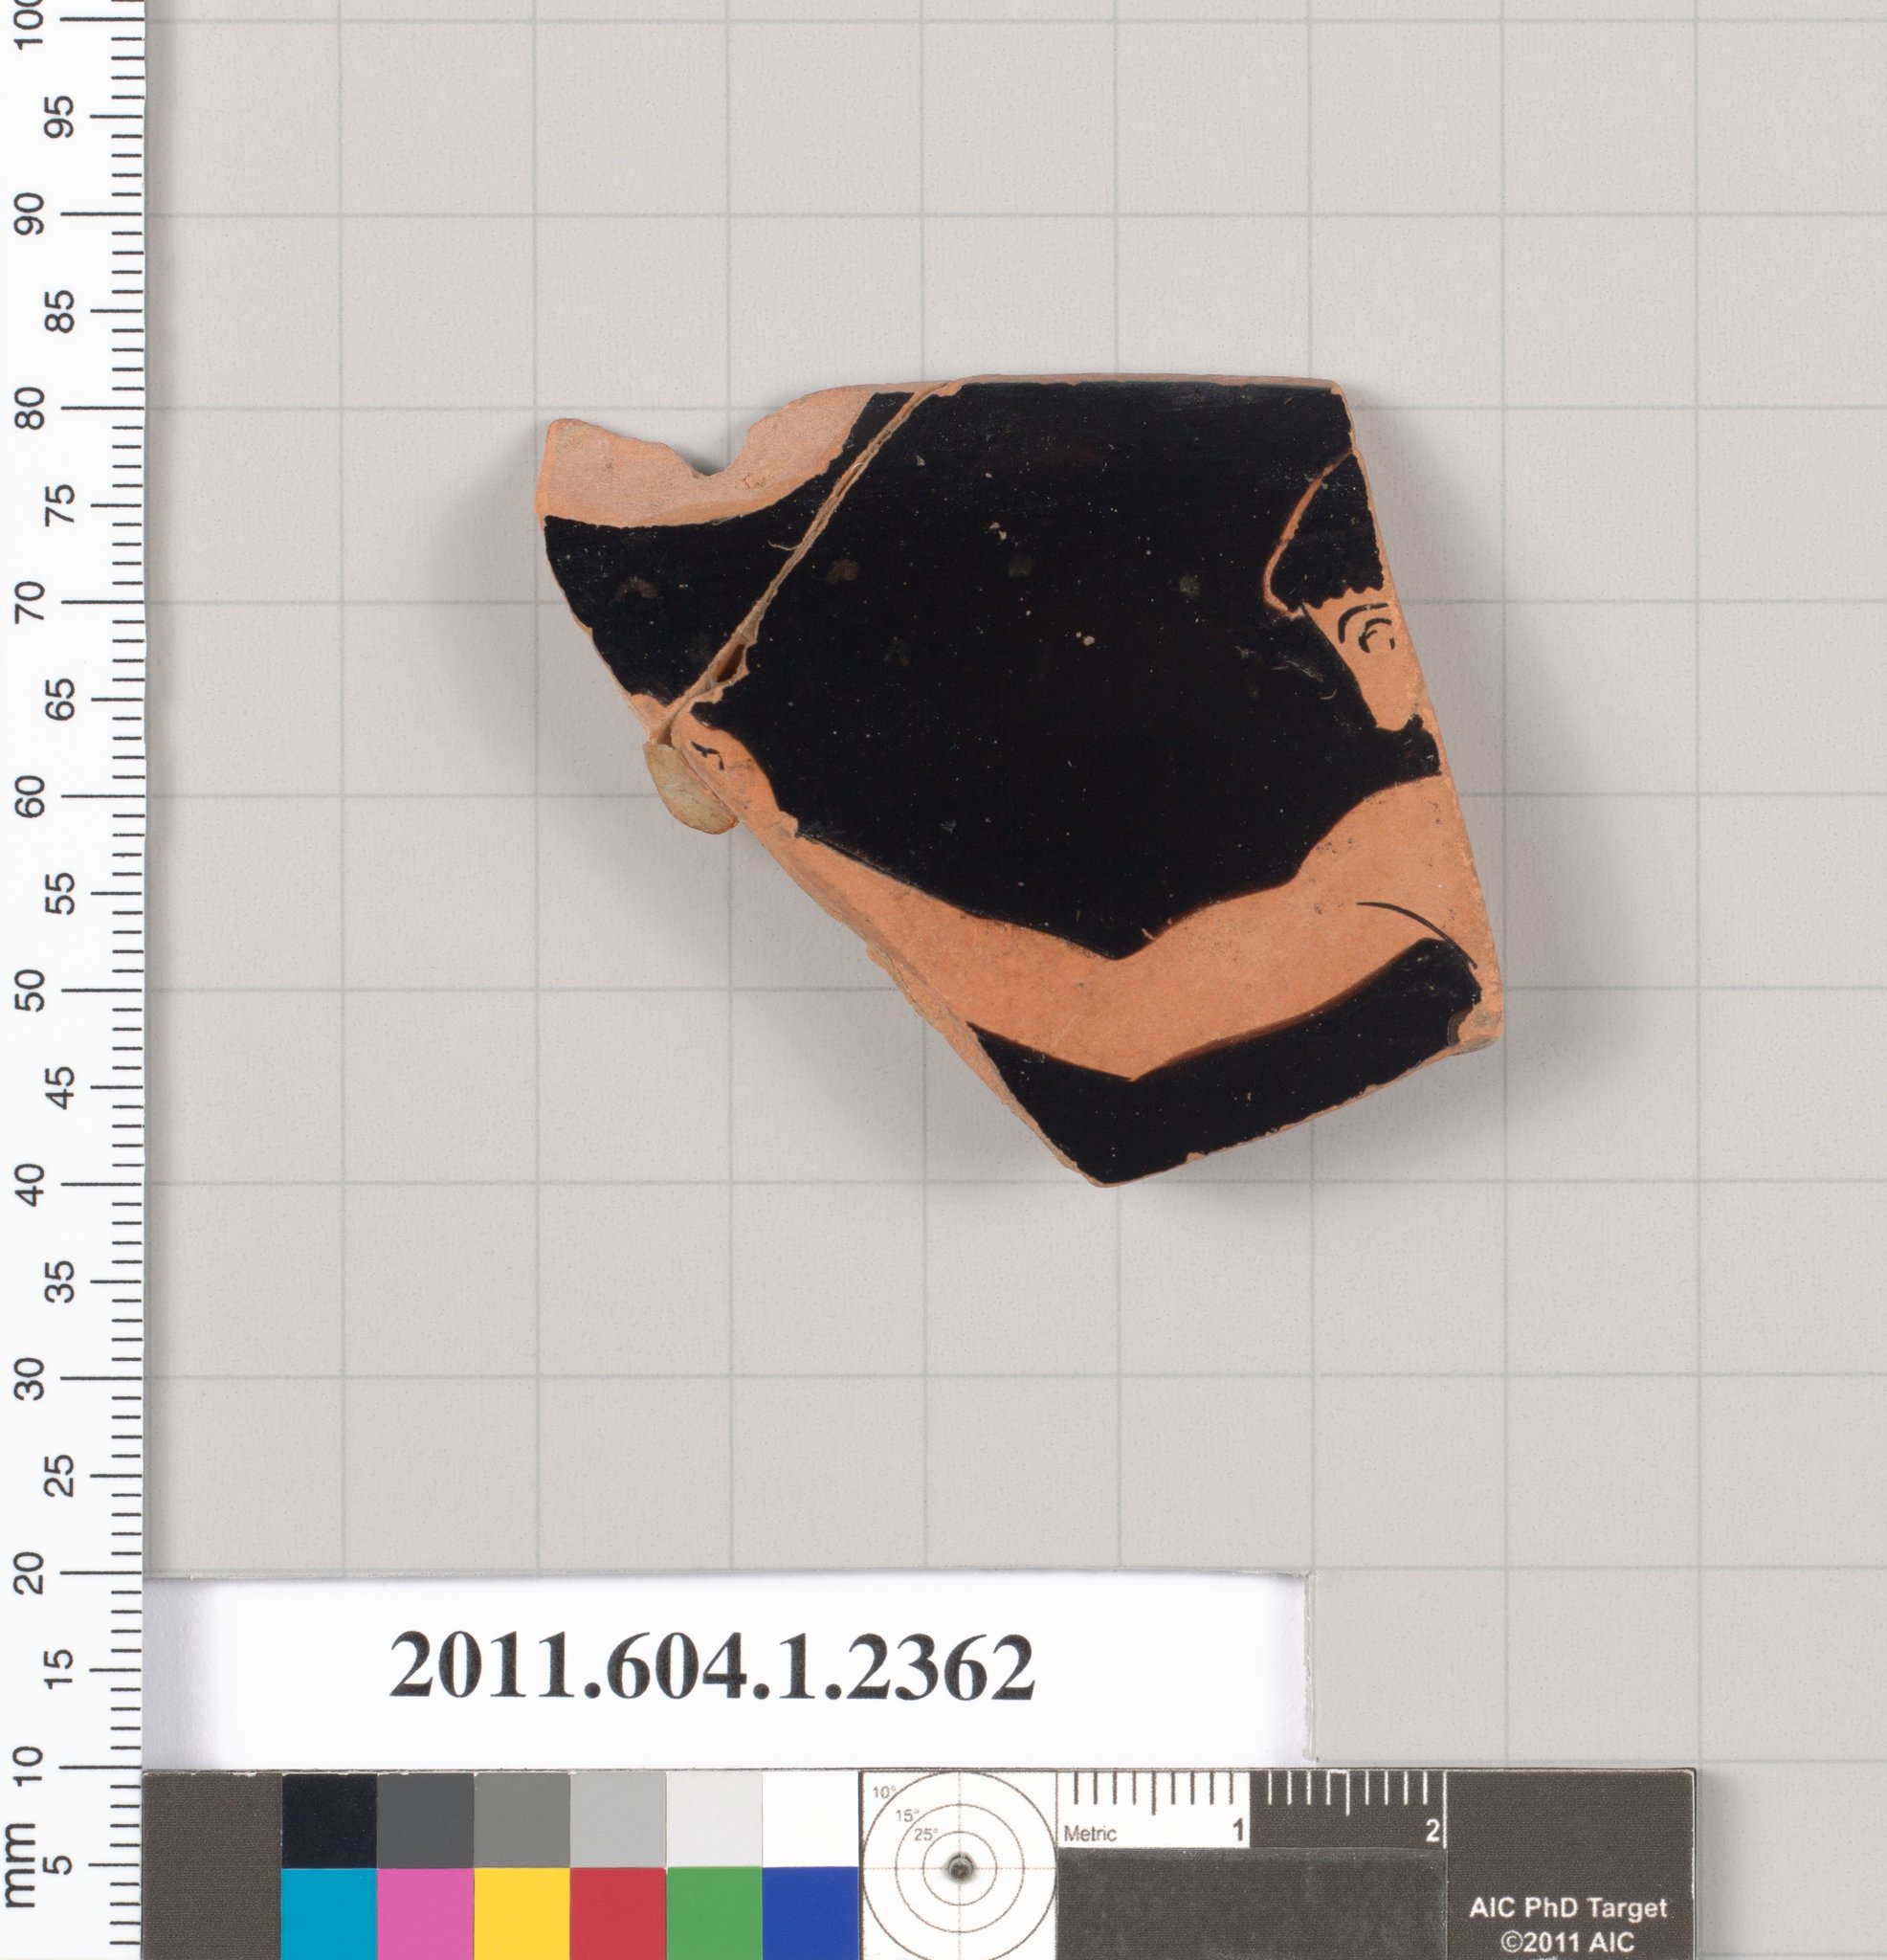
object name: kylix fragment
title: Terracotta rim fragment of a kylix (drinking cup)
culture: greek, attic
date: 470-460 BCE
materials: terracotta